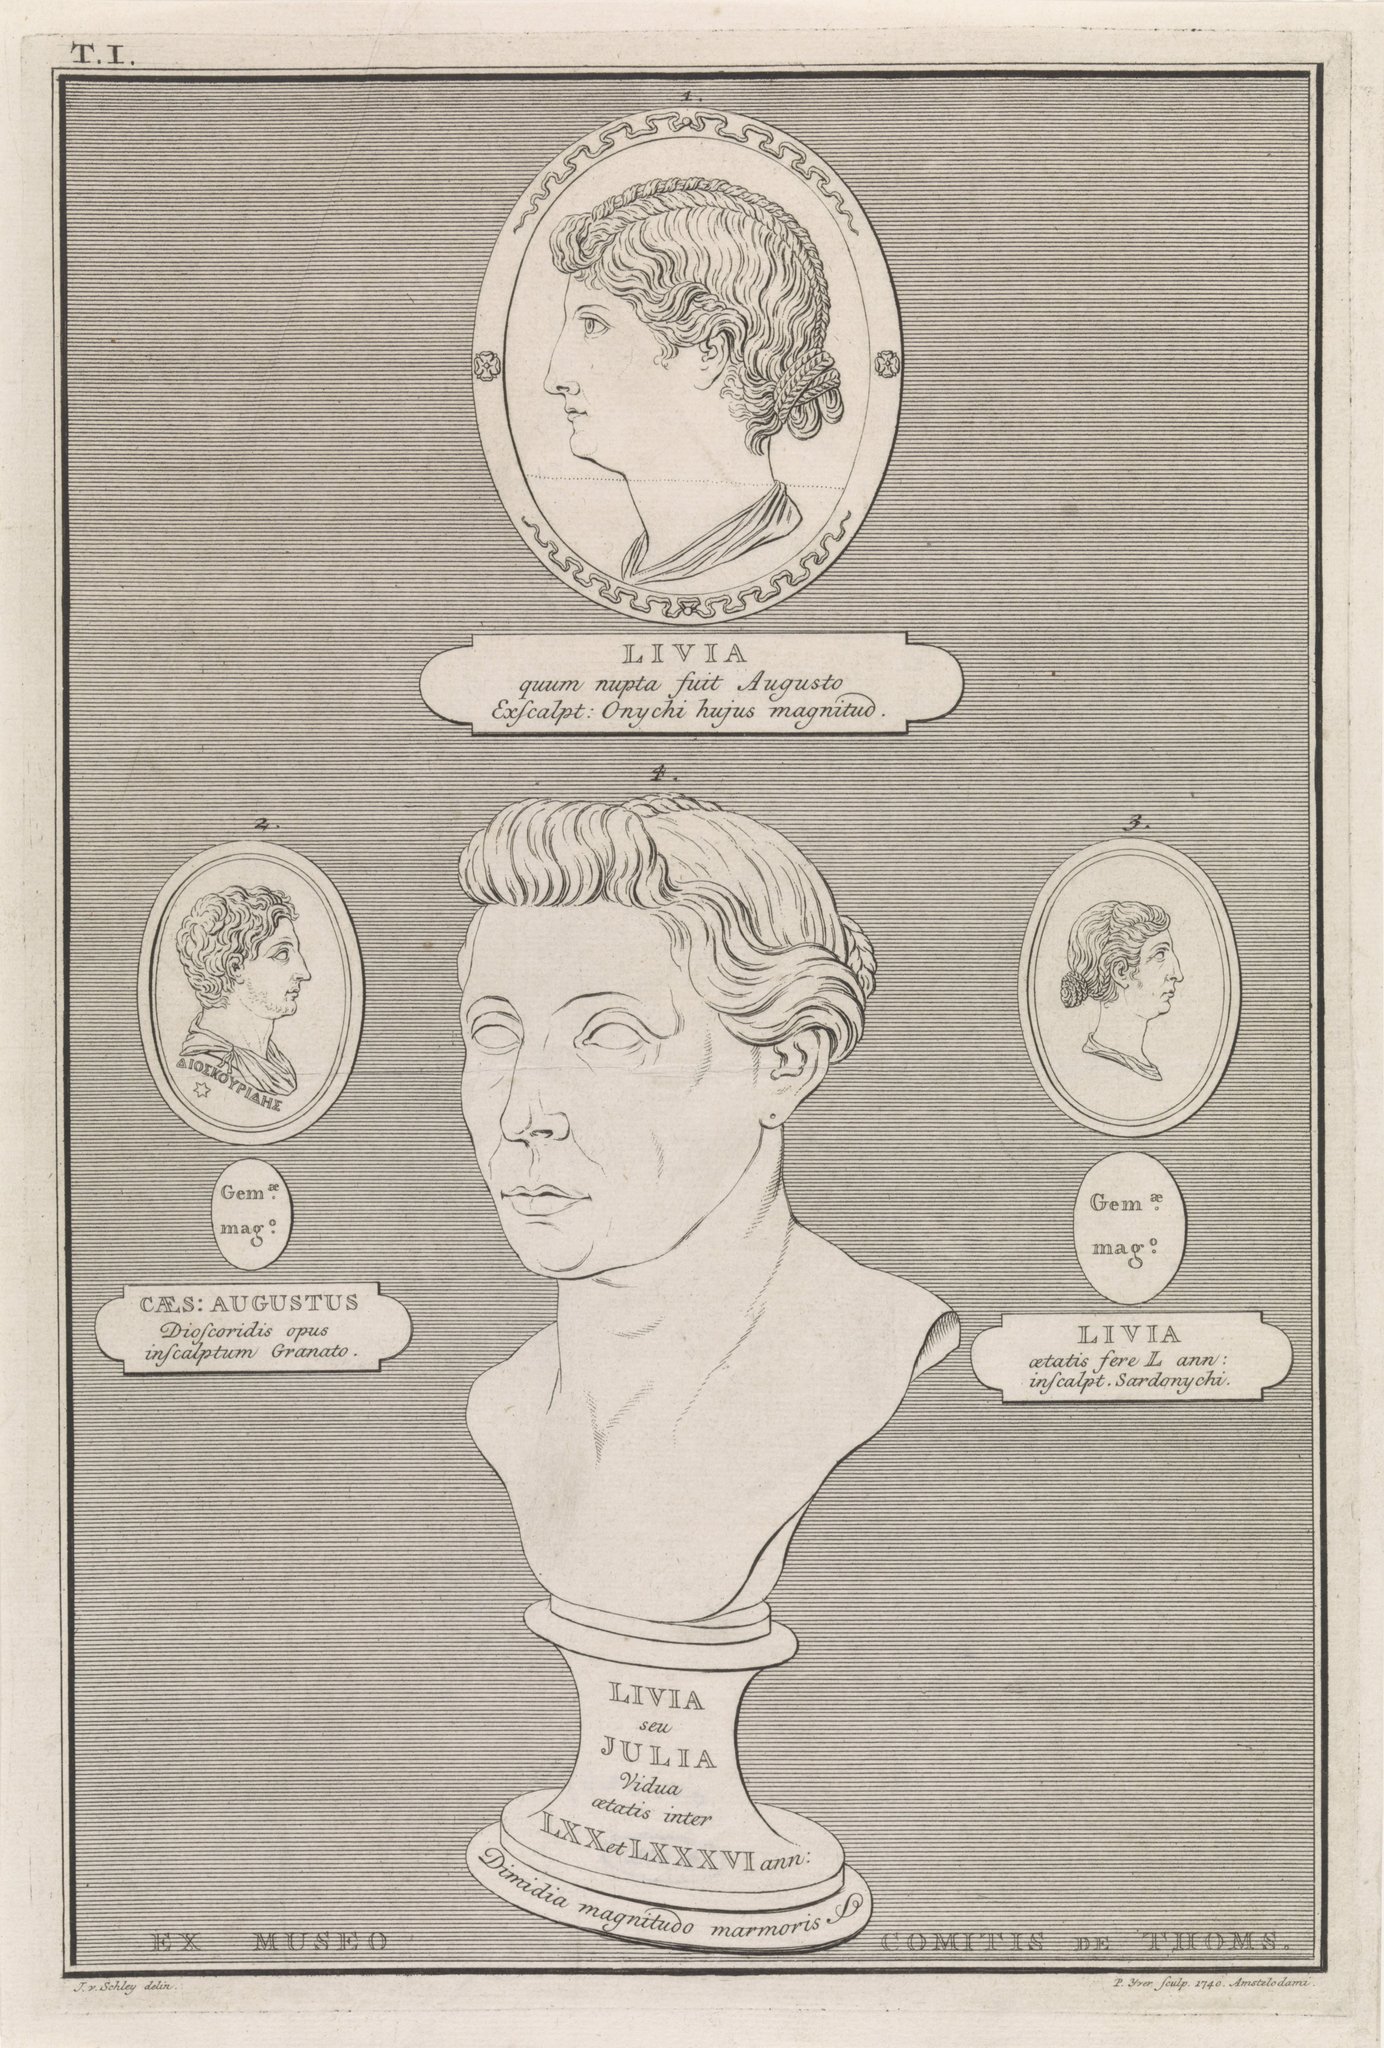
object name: print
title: Romeinse buste en gesneden stenen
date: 1740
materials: paper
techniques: etching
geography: amsterdam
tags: leiden, piece of sculpture, reproduction of a piece of sculpture, gem, gemstone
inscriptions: collector's mark: Lugt 2228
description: Gesneden stenen en een buste uit de collectie van Frederik graaf De Thoms.